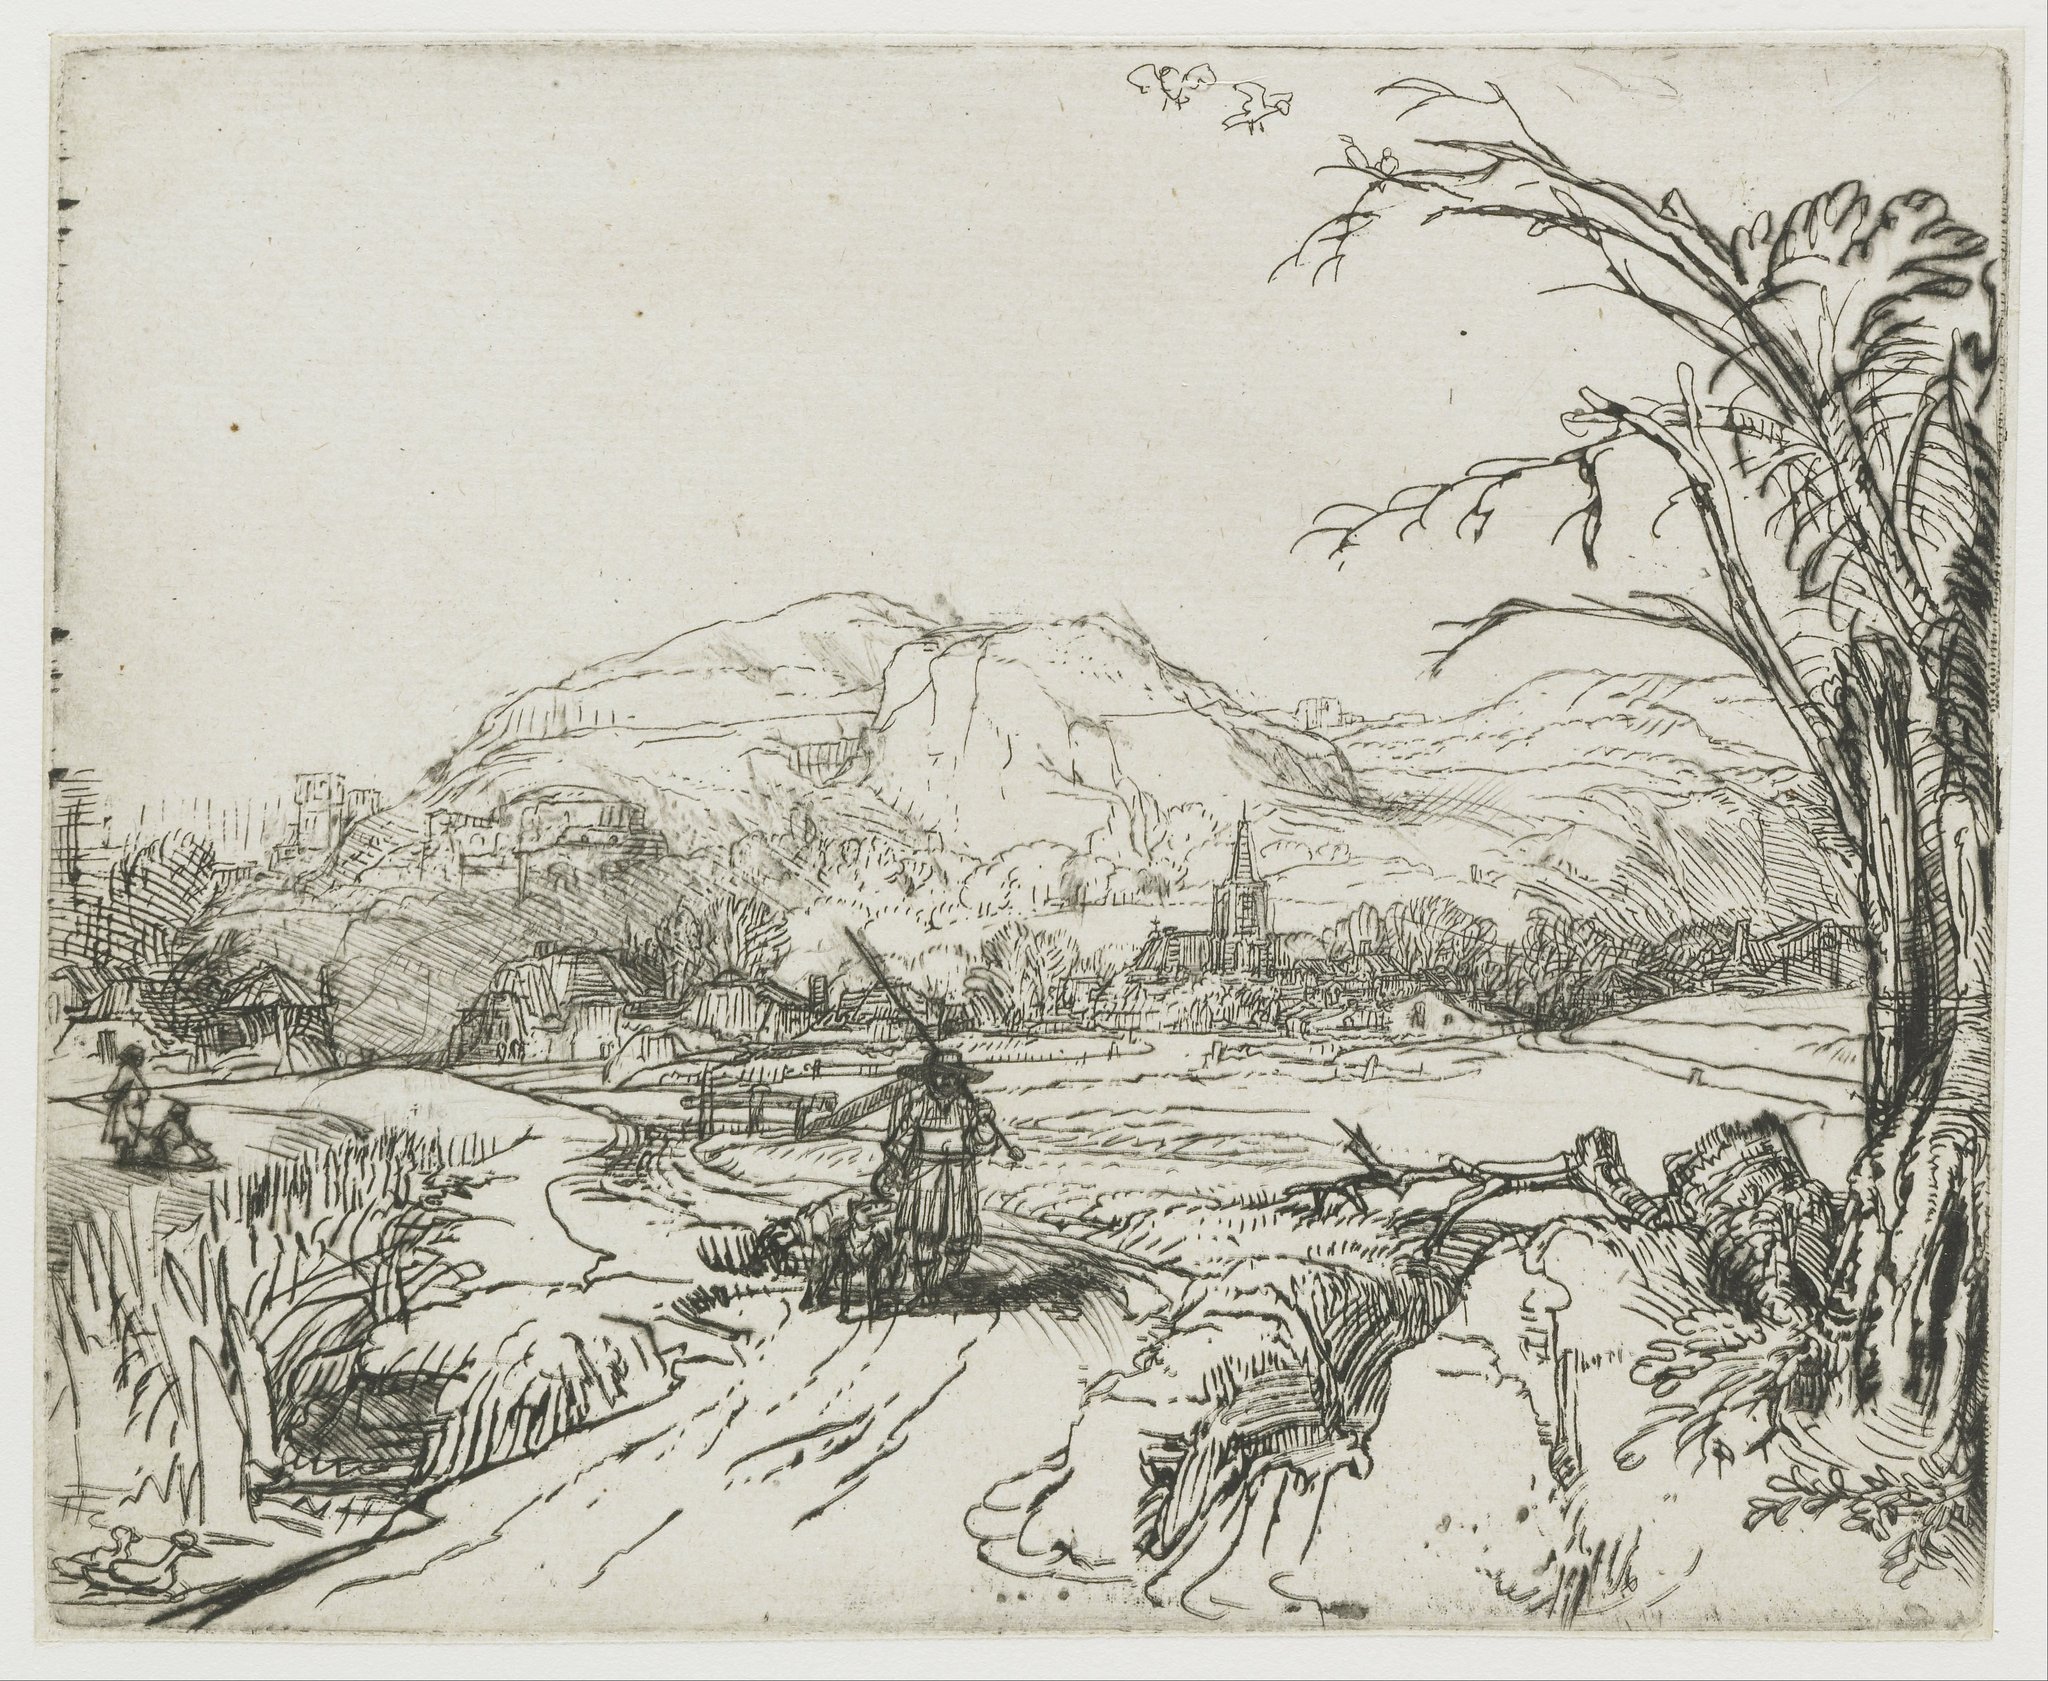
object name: print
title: Landscape with sportsman and dogs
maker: rembrandt van rijn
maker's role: draughtsman, painter, print maker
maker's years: 1606-1669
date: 1648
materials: paper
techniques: drypoint, etching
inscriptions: collector's mark: Lugt 2228